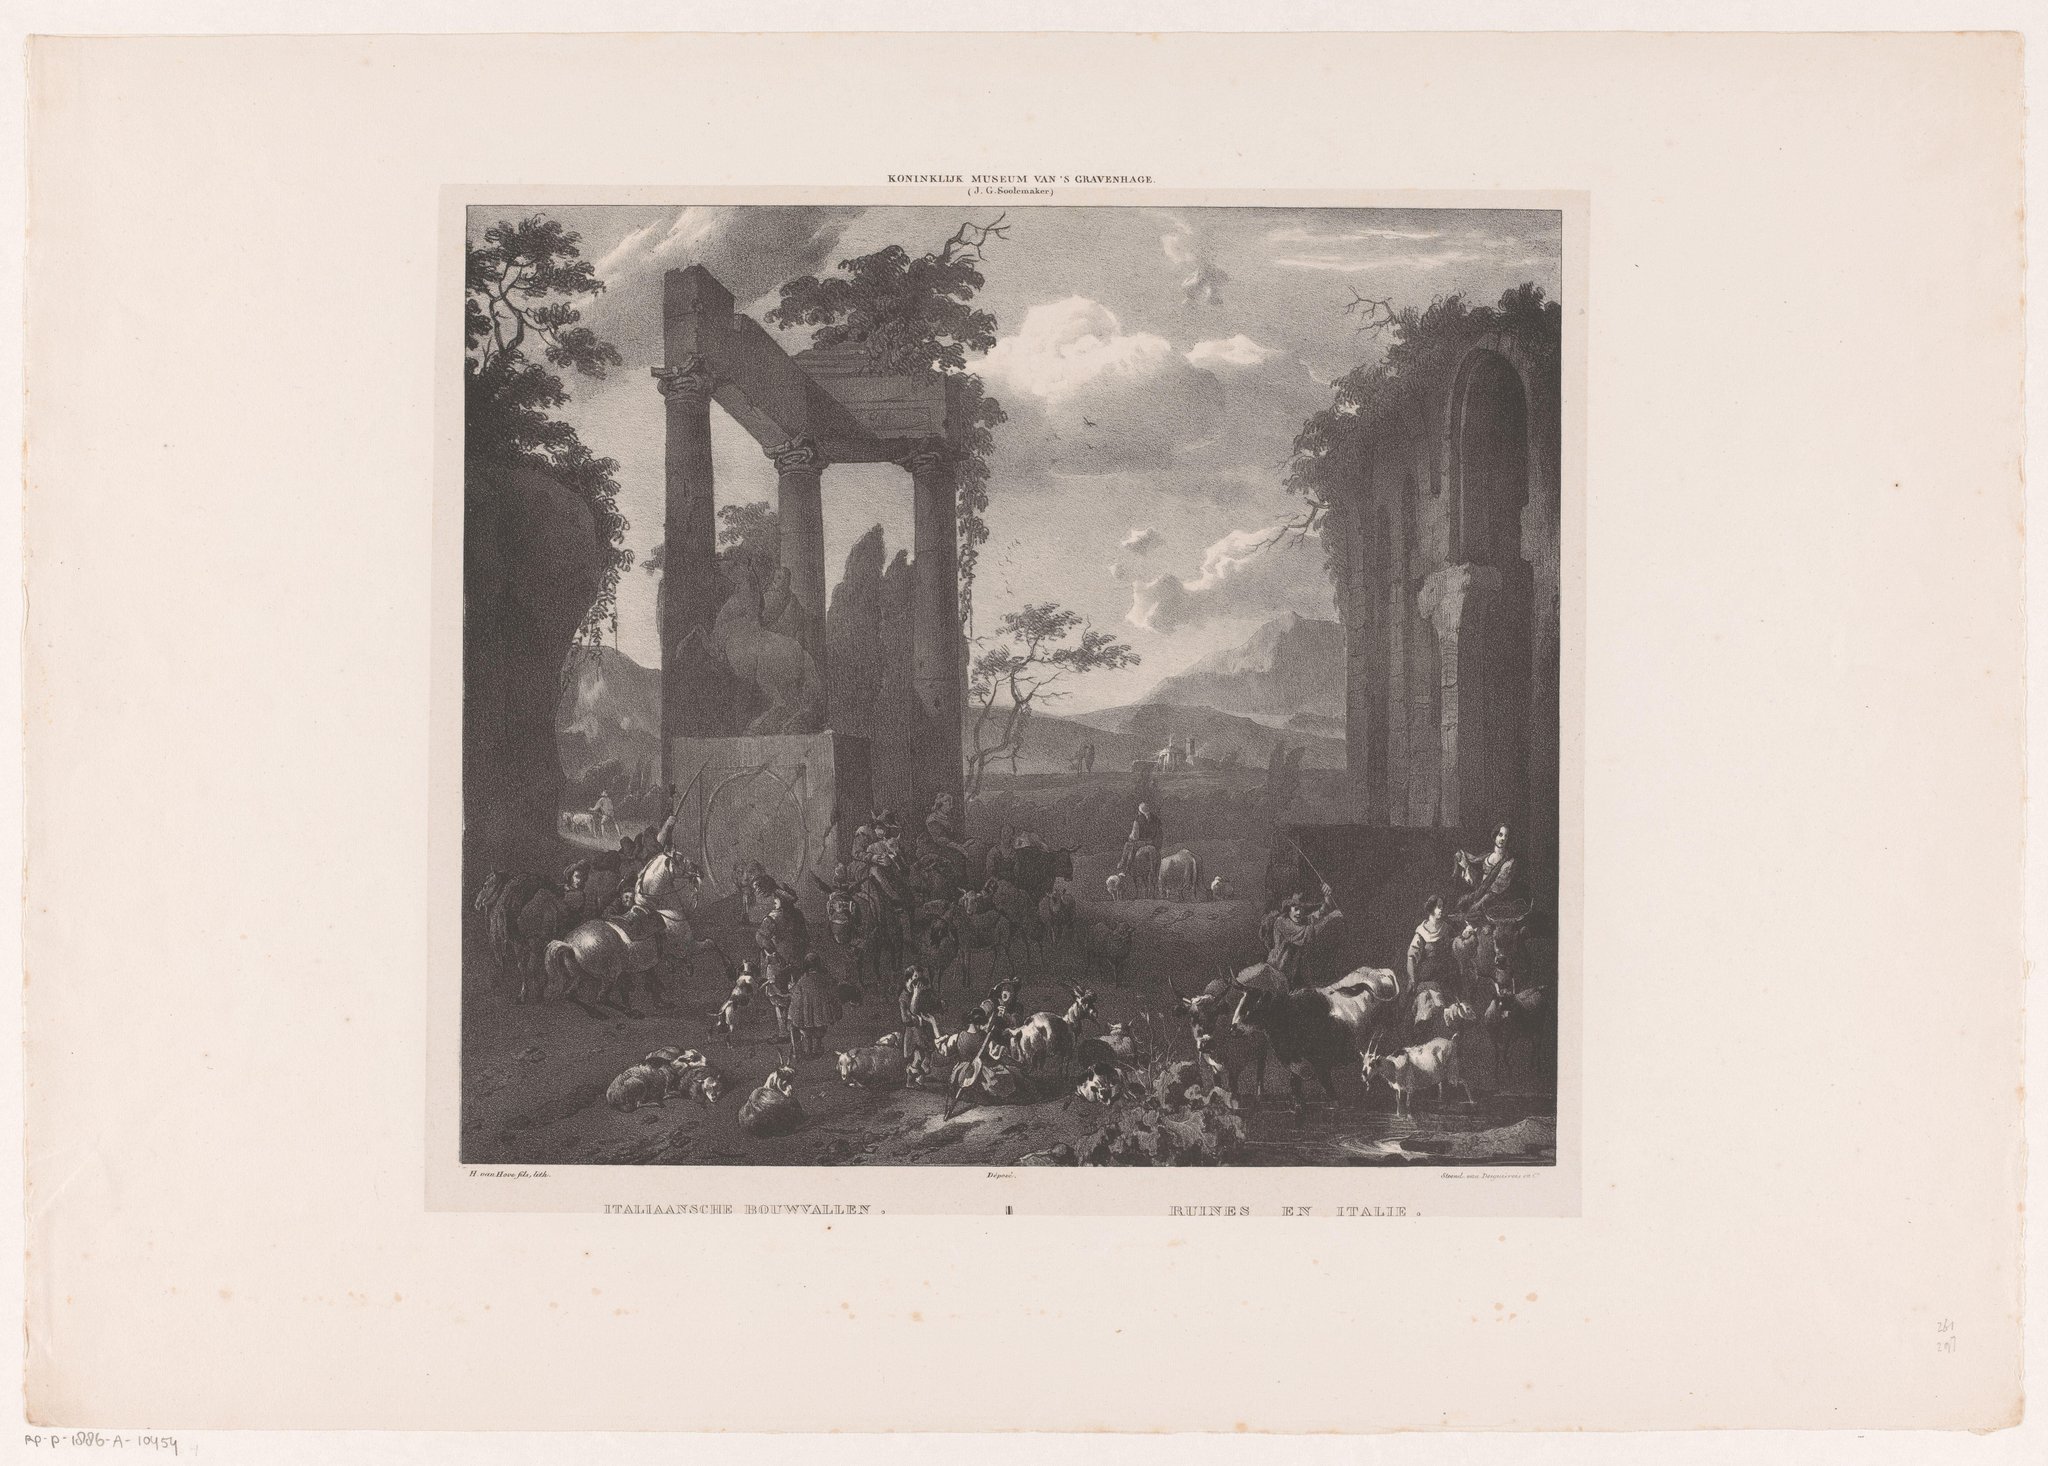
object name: print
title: Het Koninklijk Museum van 's Gravenhage op steen gebragt. Opgedragen aan Hare Majesteit De Koningin Der Nederlanden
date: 1828-1833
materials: paper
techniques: lithograph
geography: amsterdam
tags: cattle, landscape with ruins (+ city(-scape) with figures, staffage), classical antiquity (historical epoch), italy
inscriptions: : ‘Déposé.’, collector's mark: Lugt 2228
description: Links op een grote sokkel een sculptuur van een steigerend paard met daarnaast een figuur, mogelijk Castor of Pollux. Tussen de zuilen en bogen lopen vee en figuren.